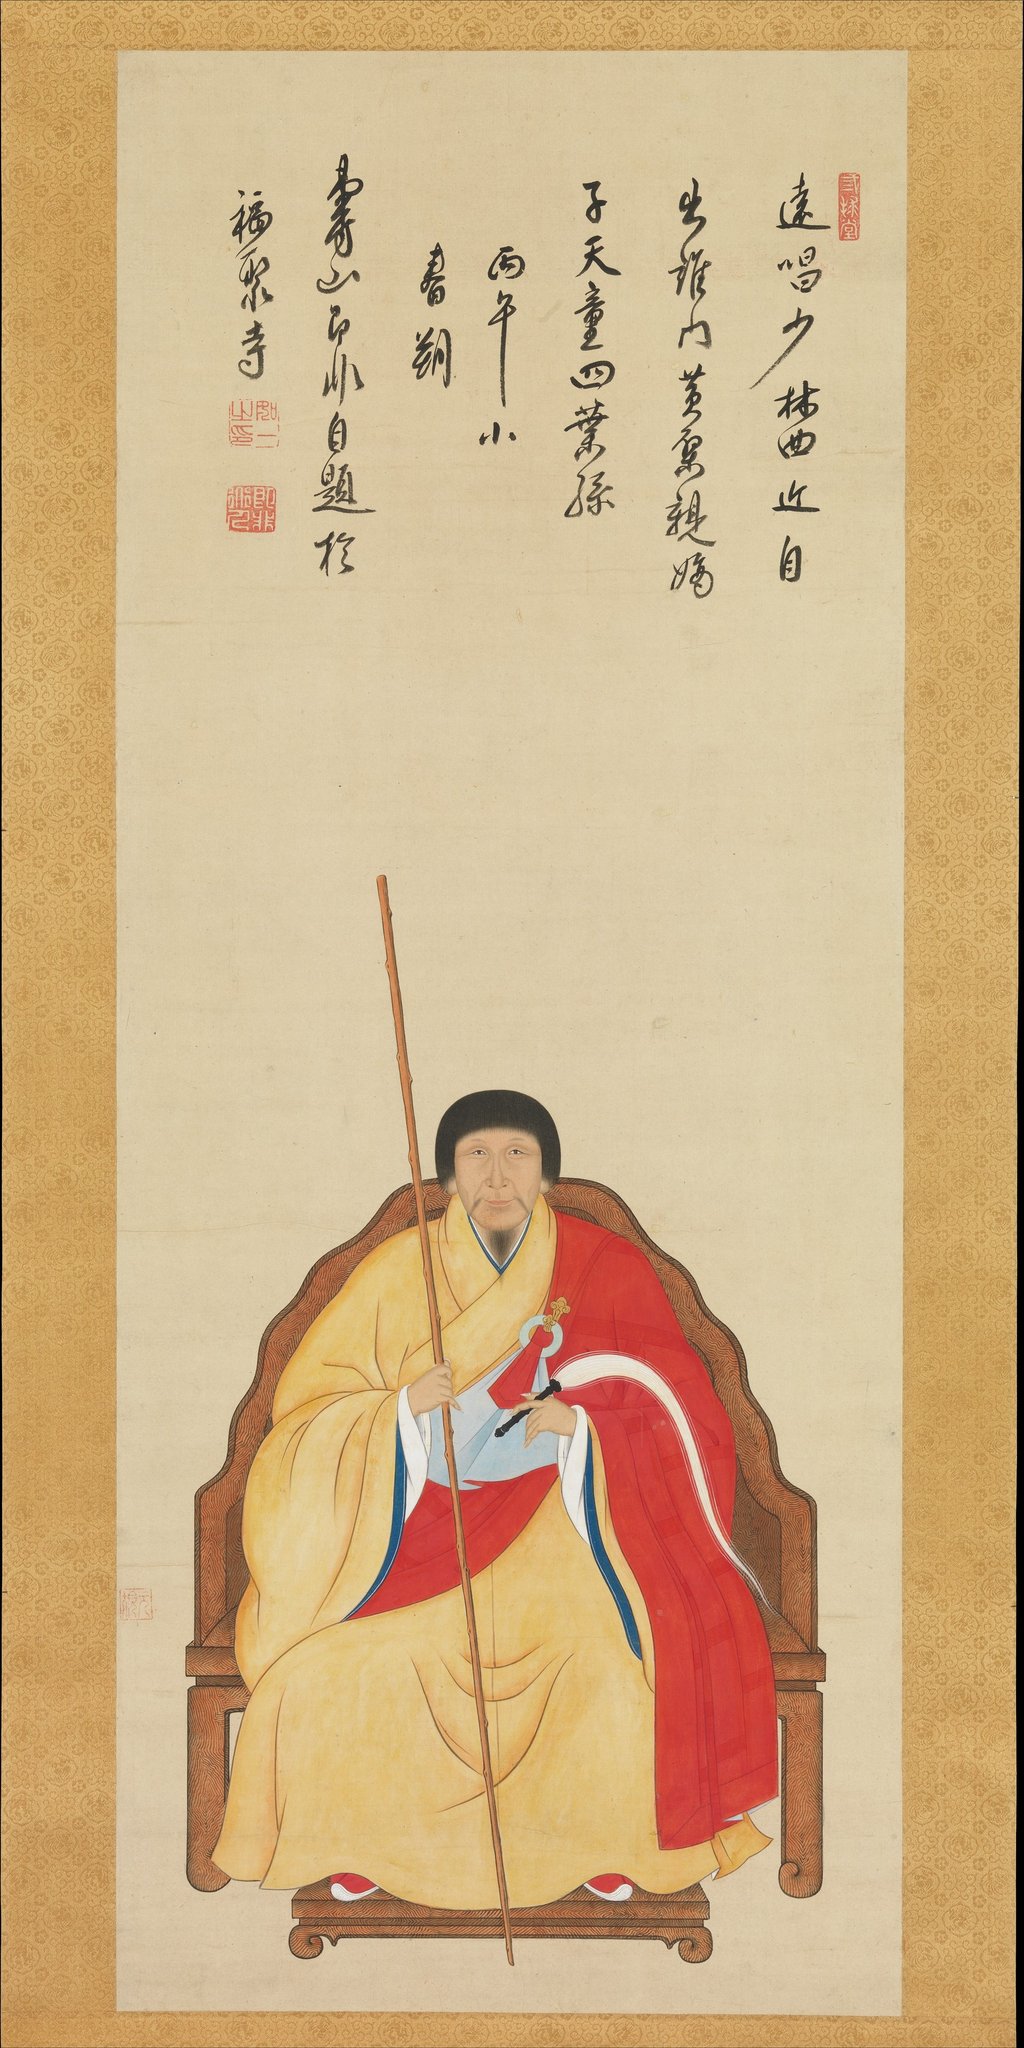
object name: hanging scroll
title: Portrait of the Ōbaku Zen Monk Jifei Ruyi (Sokuhi Nyoitsu)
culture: japanese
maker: kita genki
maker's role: artist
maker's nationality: japanese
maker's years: 1664-1698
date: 1666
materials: ink, silk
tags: men,portraits